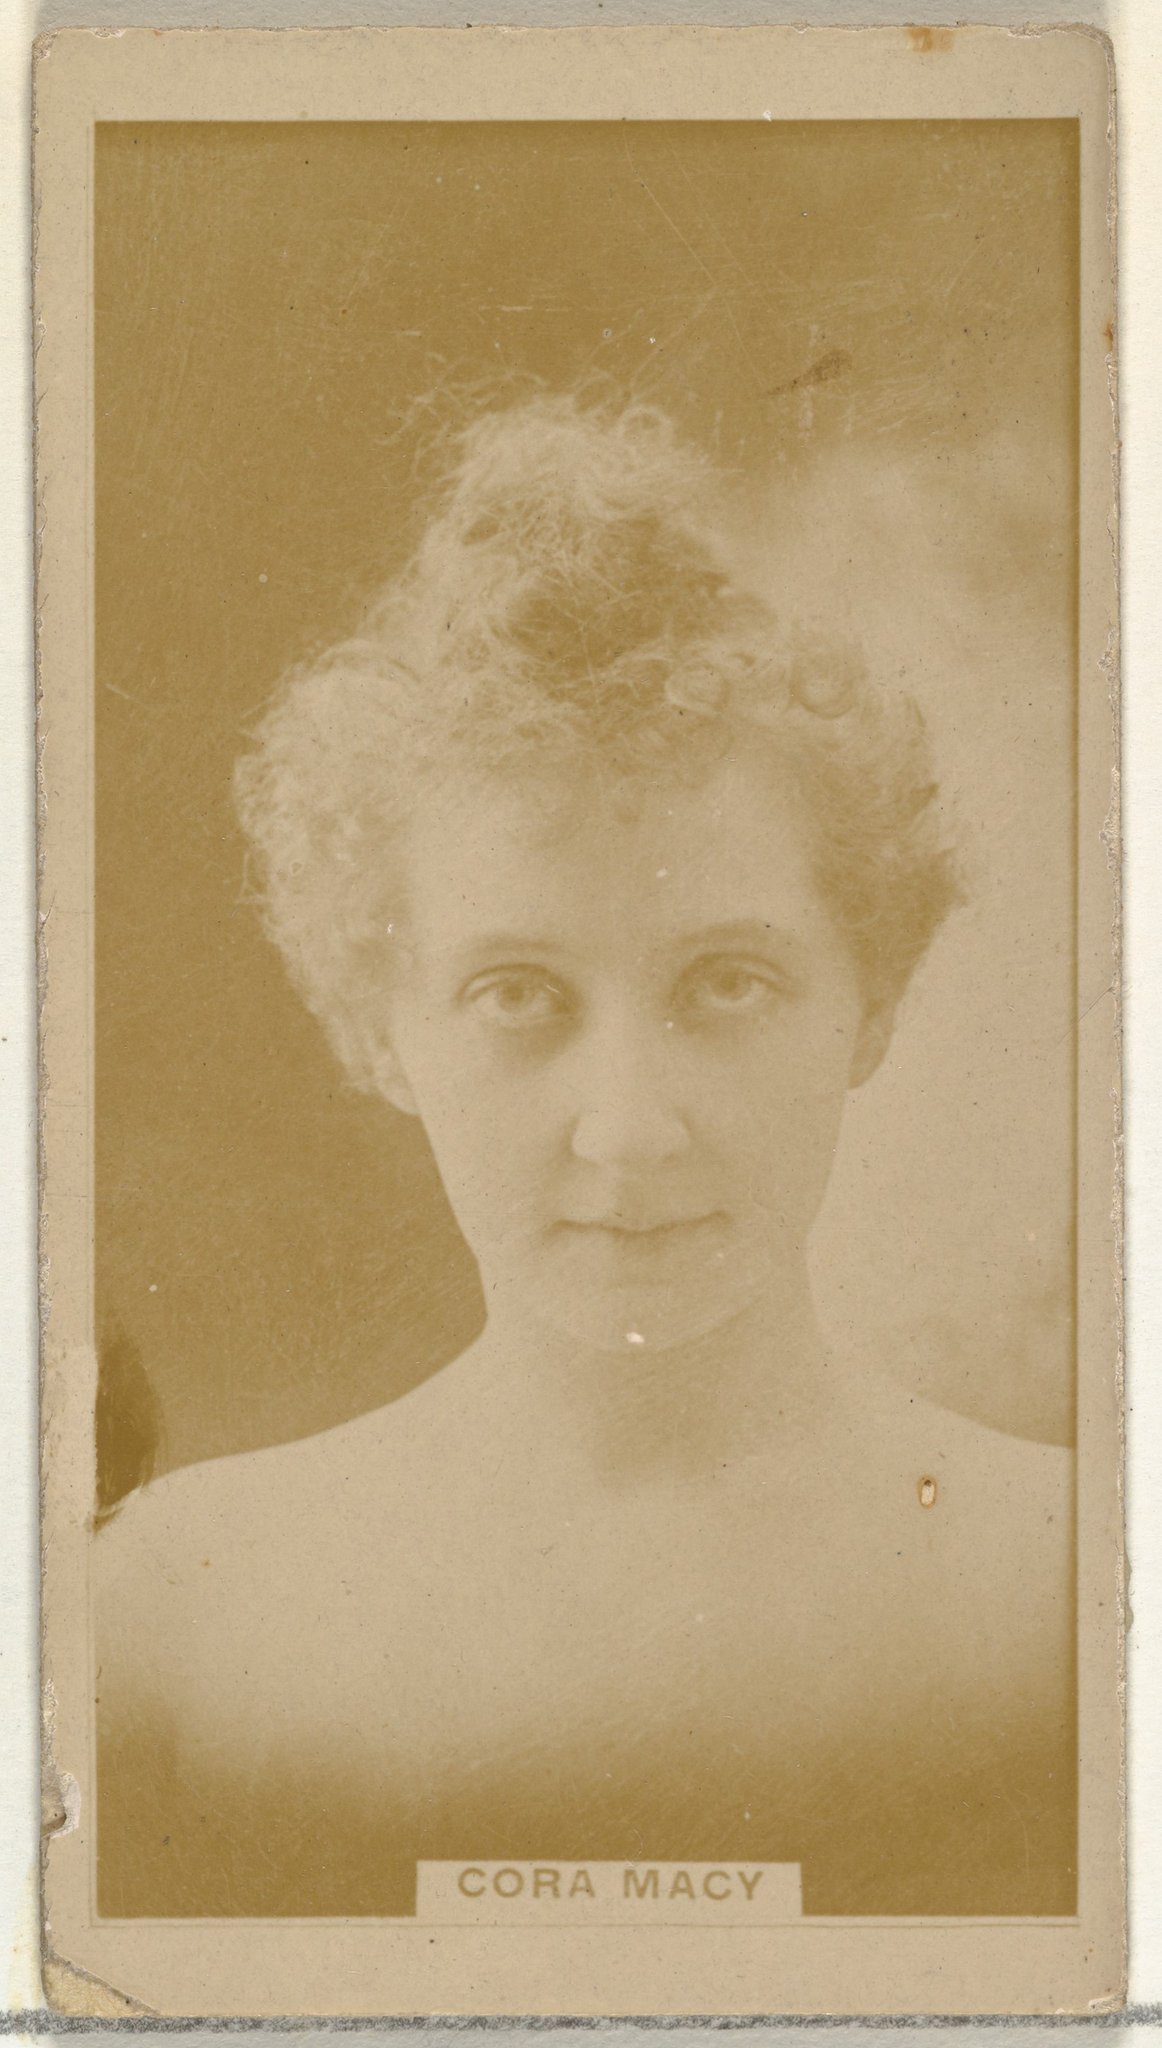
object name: photograph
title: Cora Macy, from the Actors and Actresses series (N145-8) issued by Duke Sons & Co. to promote Duke Cigarettes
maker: w. duke, sons & co.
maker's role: publisher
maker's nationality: american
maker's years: 1870-1920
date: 1891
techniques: albumen silver print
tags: portraits,women,actresses